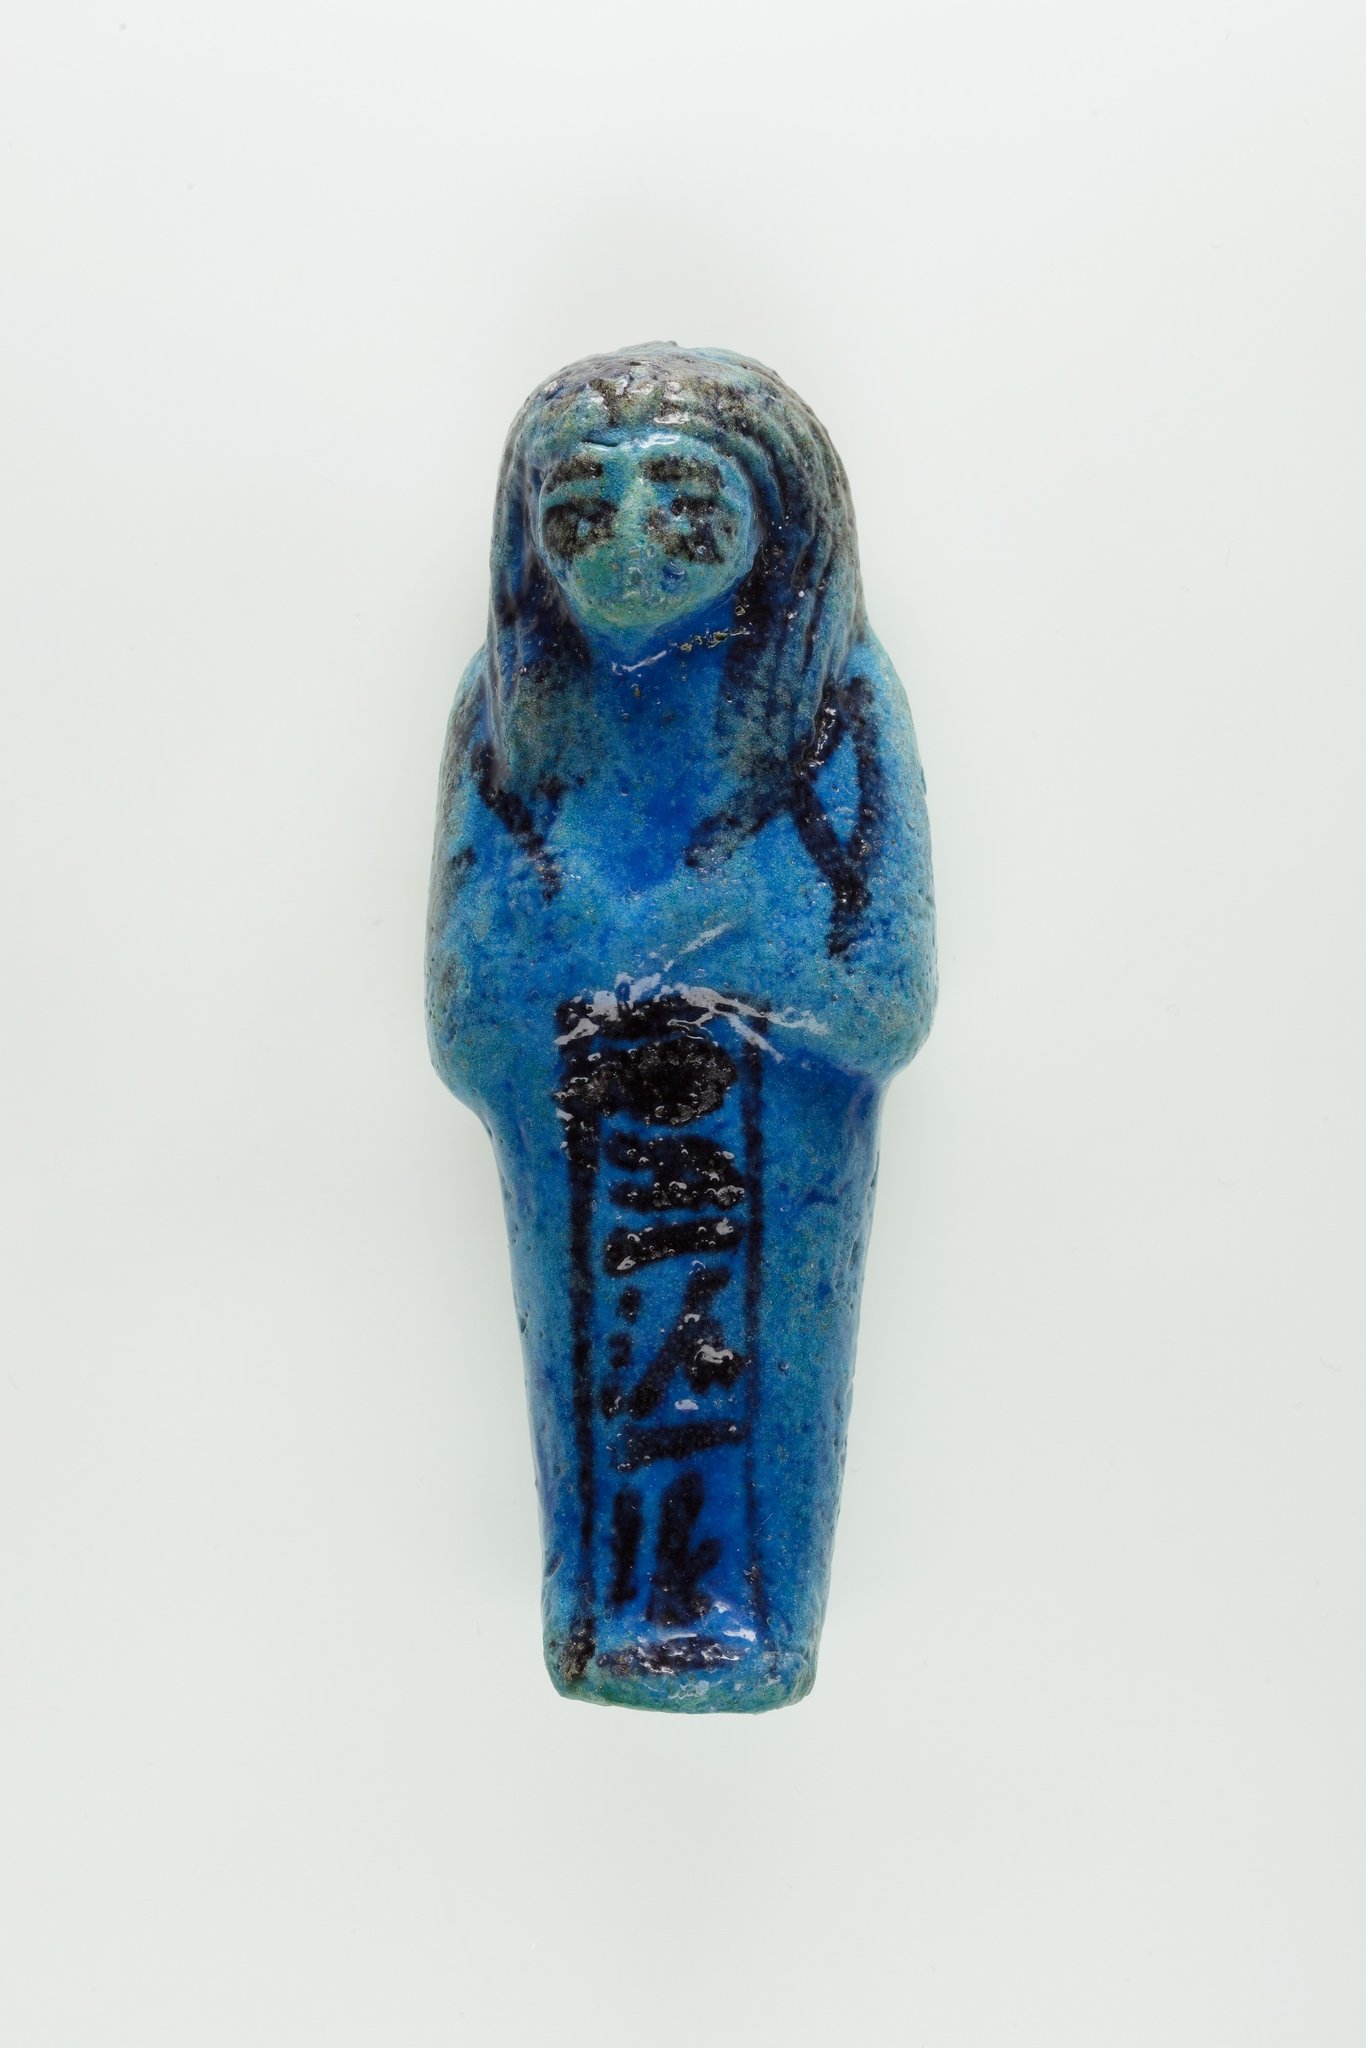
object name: shabti, worker, nauny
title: Worker Shabti of Nauny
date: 1050 BCE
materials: faience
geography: egypt